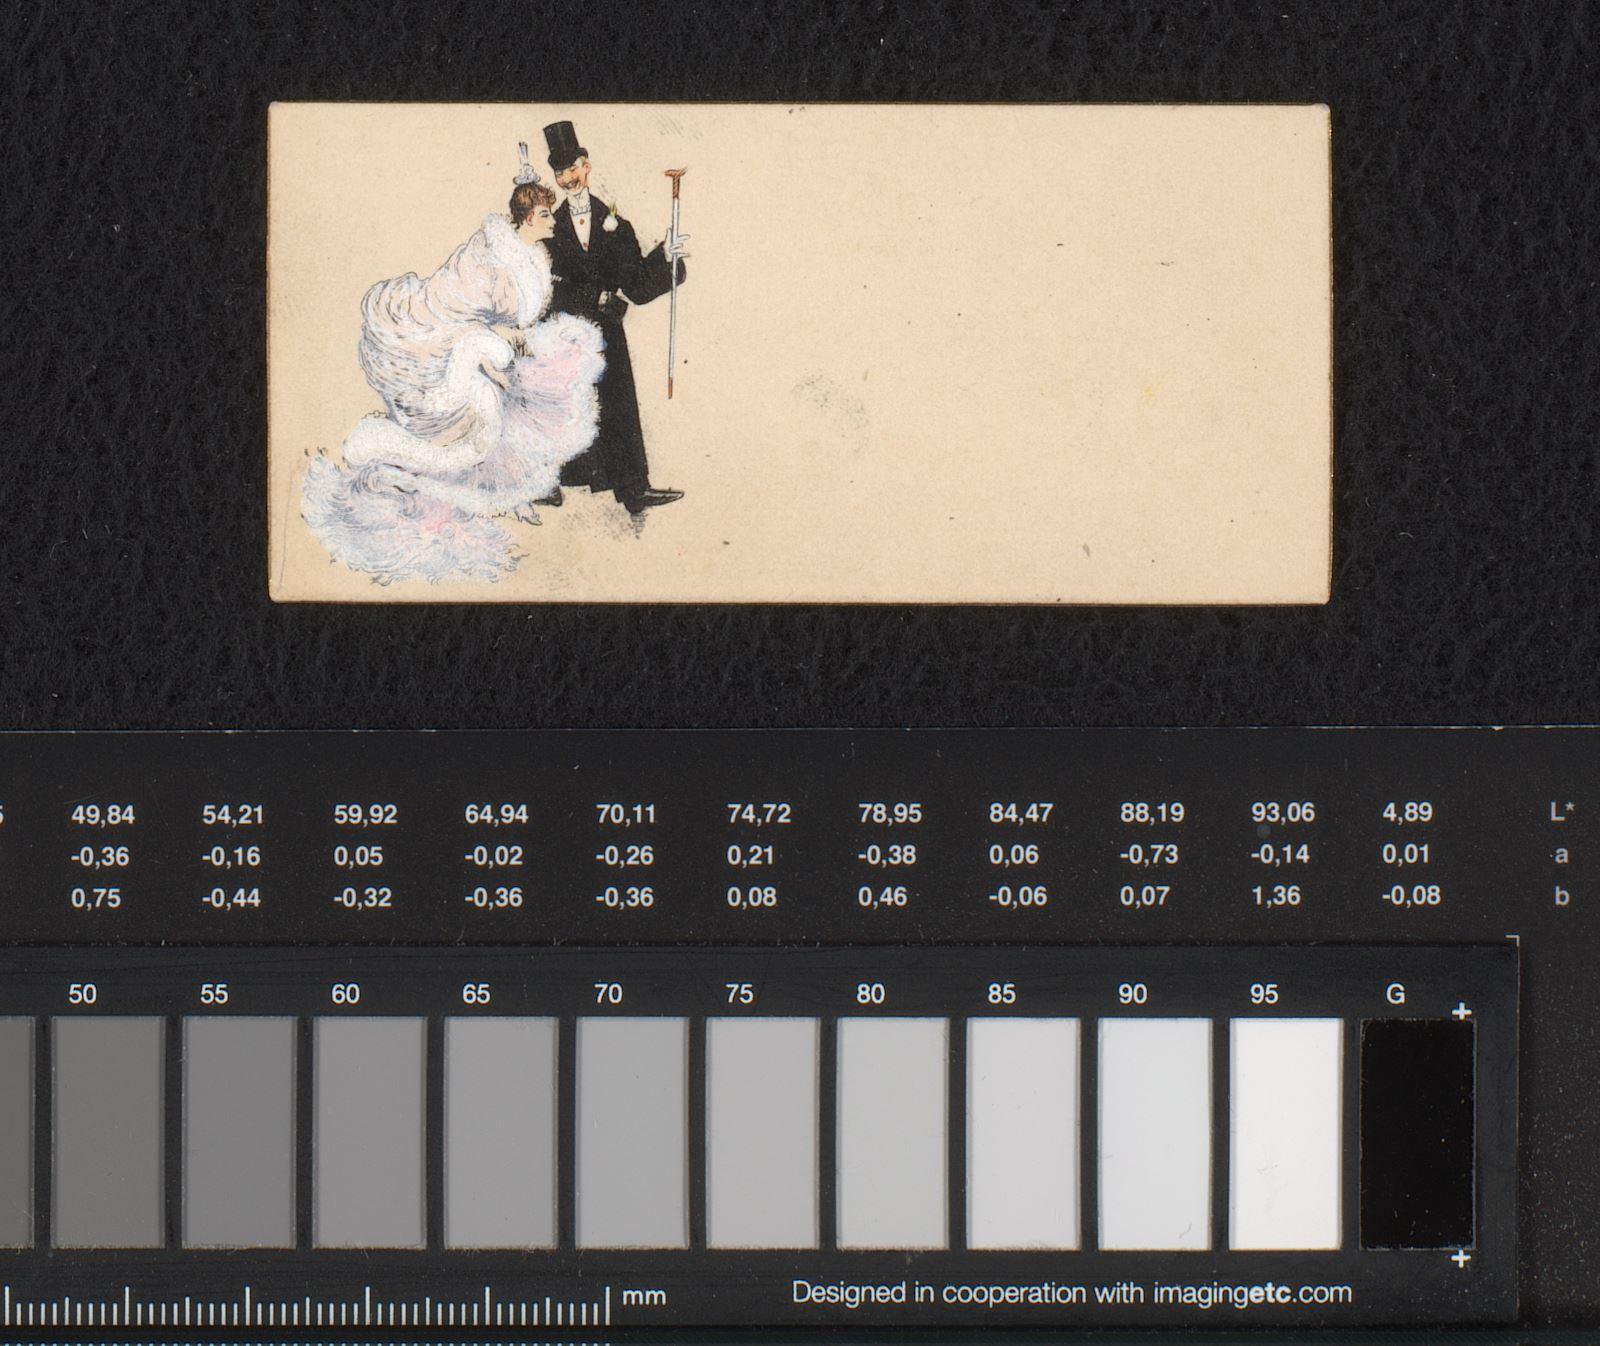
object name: photomechanical print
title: Man in rokkostuum met hoge hoed en vrouw in baljurk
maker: Anonymous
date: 1870-1920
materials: paint, paper, watercolor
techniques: hand coloring, printing block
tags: party clothes, festive attire, walking-stick, staff, dress, gown: ball gown, head-gear: top hat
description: Mogelijk een (oningevulde) plaatskaart voor een diner. Bij gebrek aan gegevens over de vervaardiger is voor de bepaling van de rechten van dit object gebruik gemaakt van de vervaardigingsdatum.